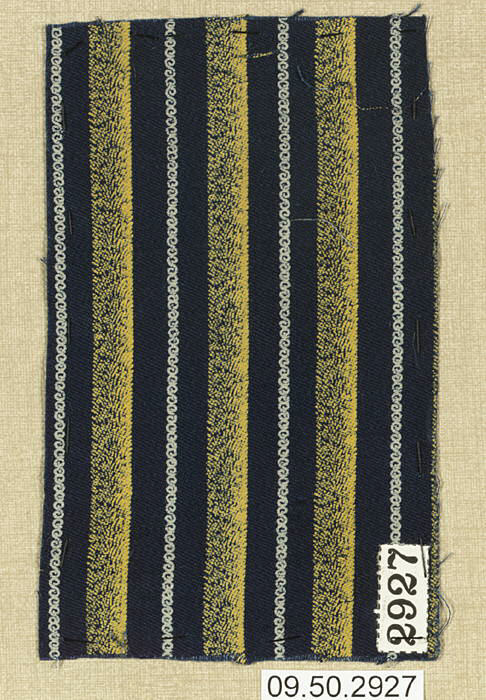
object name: piece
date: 1801-1900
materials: cotton